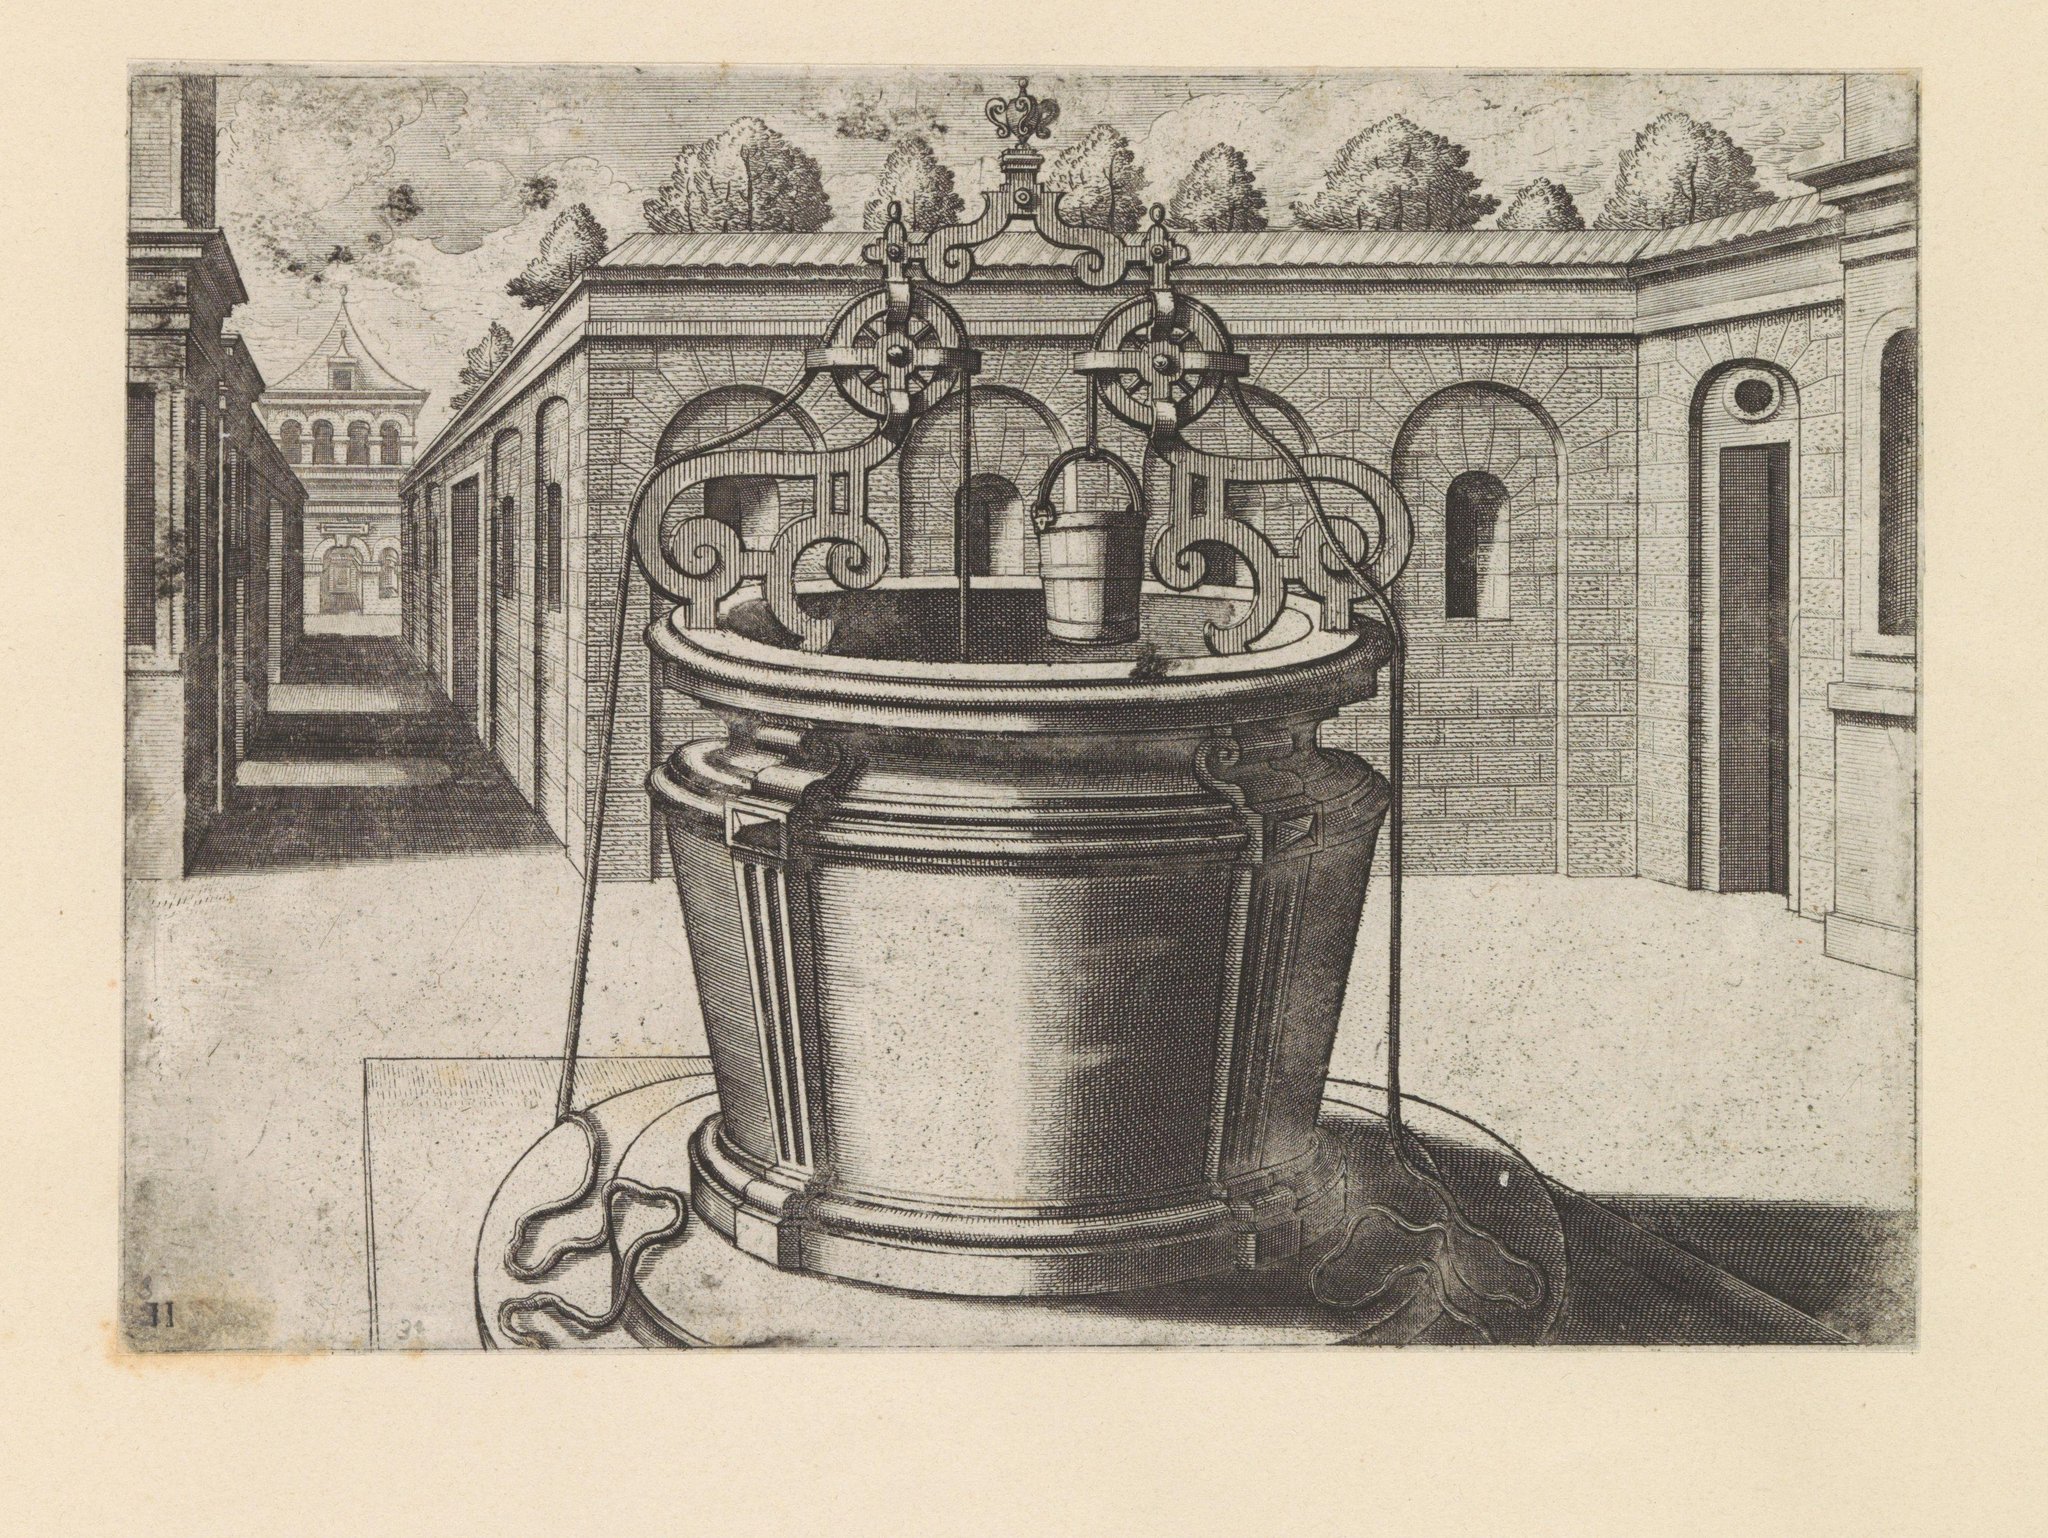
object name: album leaf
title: Waterputten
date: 1574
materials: paper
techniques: etching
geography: antwerp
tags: well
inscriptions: inscription: ‘3’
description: Plein voor een ommuurde tuin met een ronde waterput. Op de rand zijn twee constructies van rolwerk bevestigd waaraan twee akers over katrollen hangen. De prent maakt deel uit van een album.